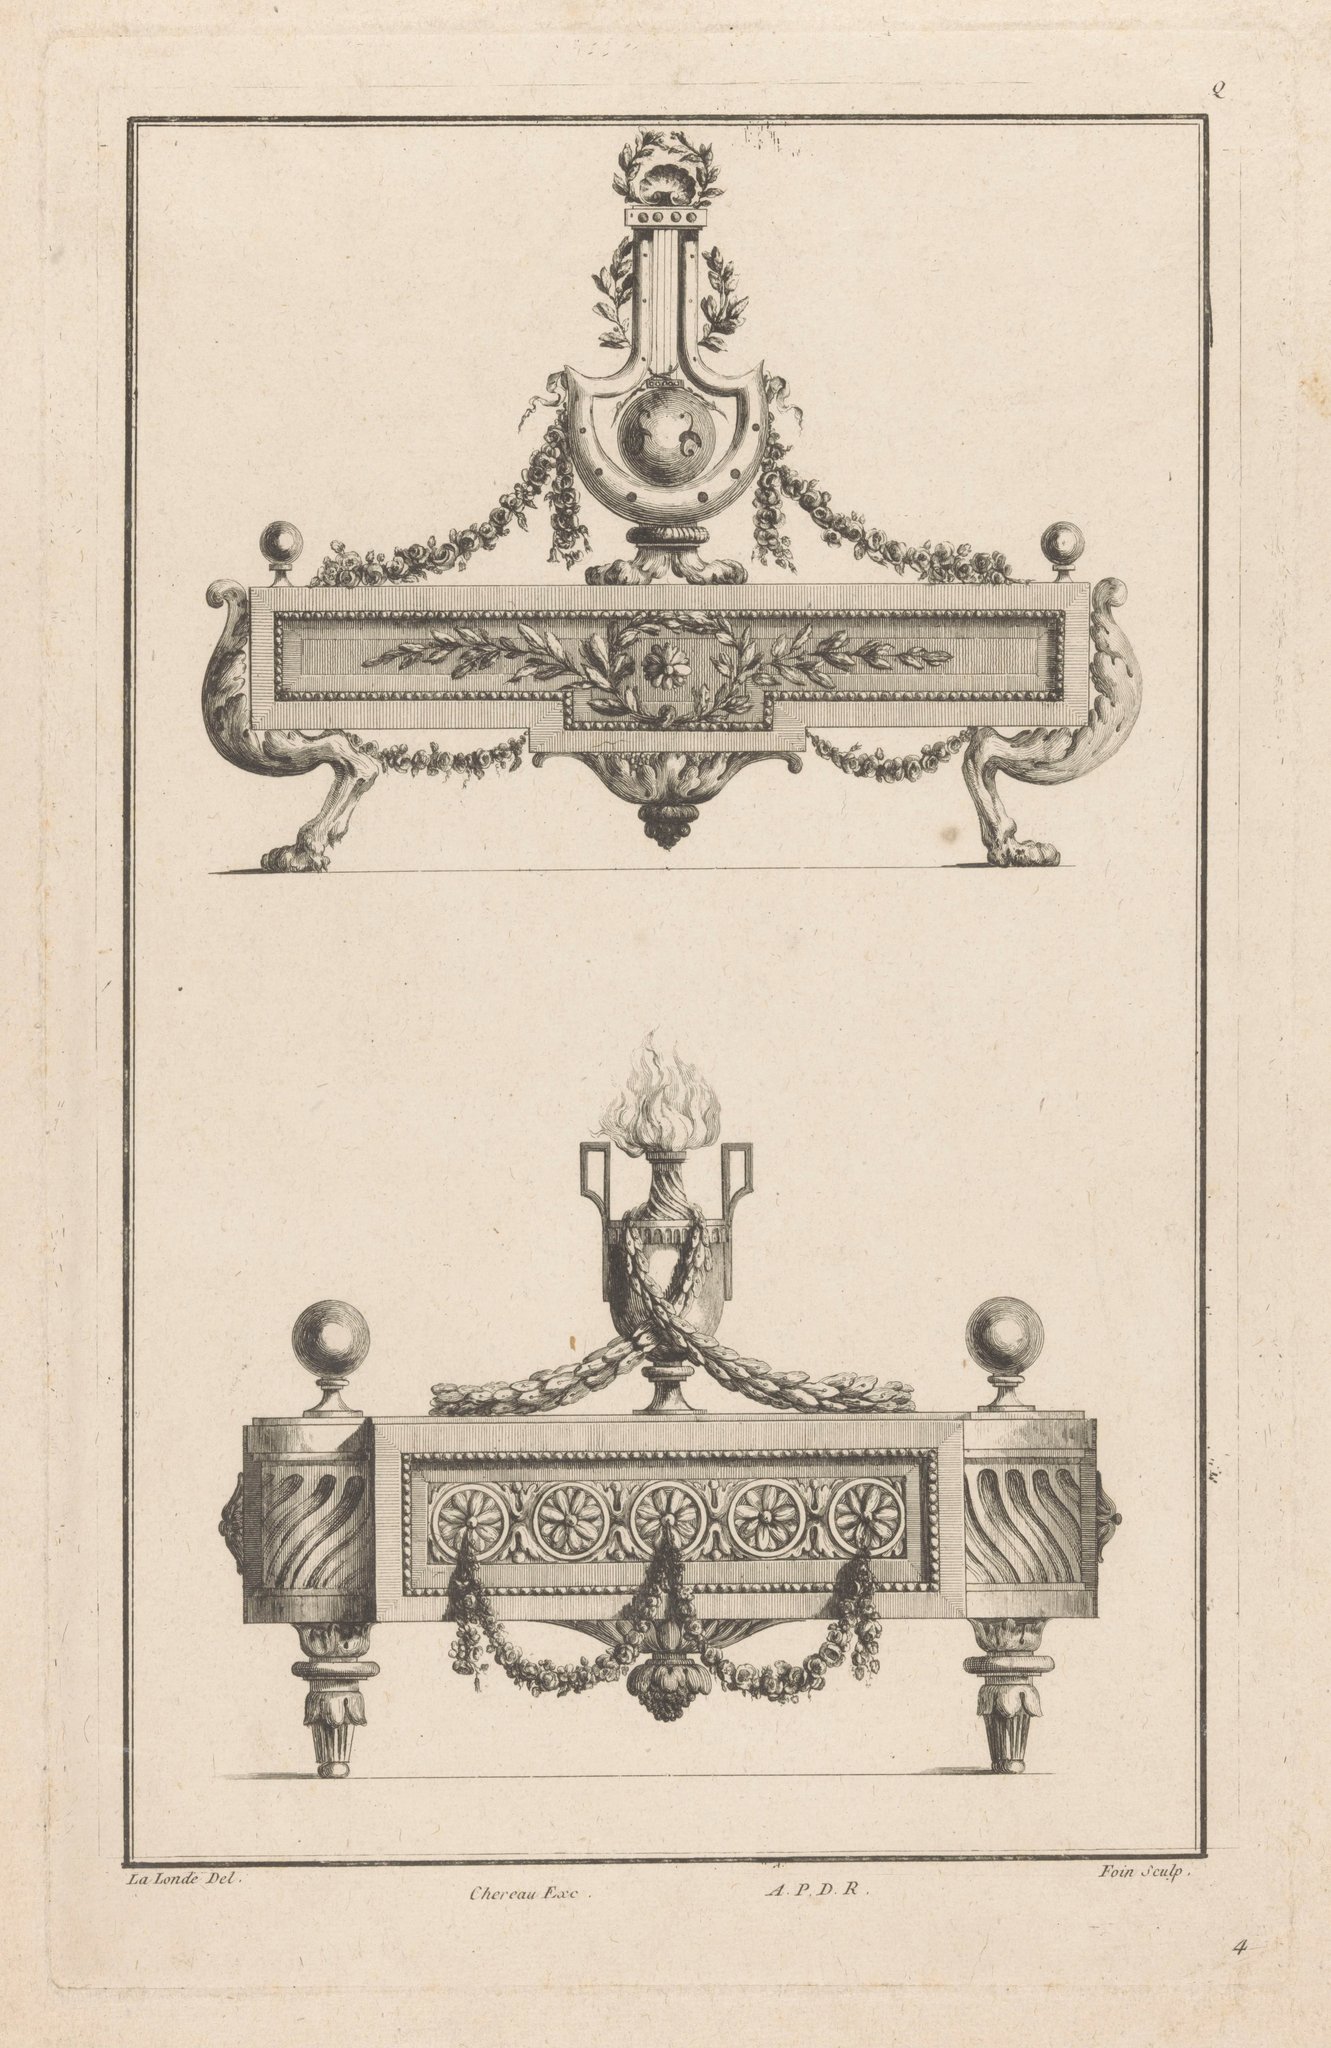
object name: print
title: Twee vuurbokken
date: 1784-1785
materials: paper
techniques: engraving, etching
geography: paris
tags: andiron, fire-dog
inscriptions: collector's mark: Lugt 2228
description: Een geornamenteerde vuurbok op leeuwenpoten met guirlandes en een lier. Daaronder een geornamenteerde vuurbok met guirlandes, twee bollen en een vaas met vuur.